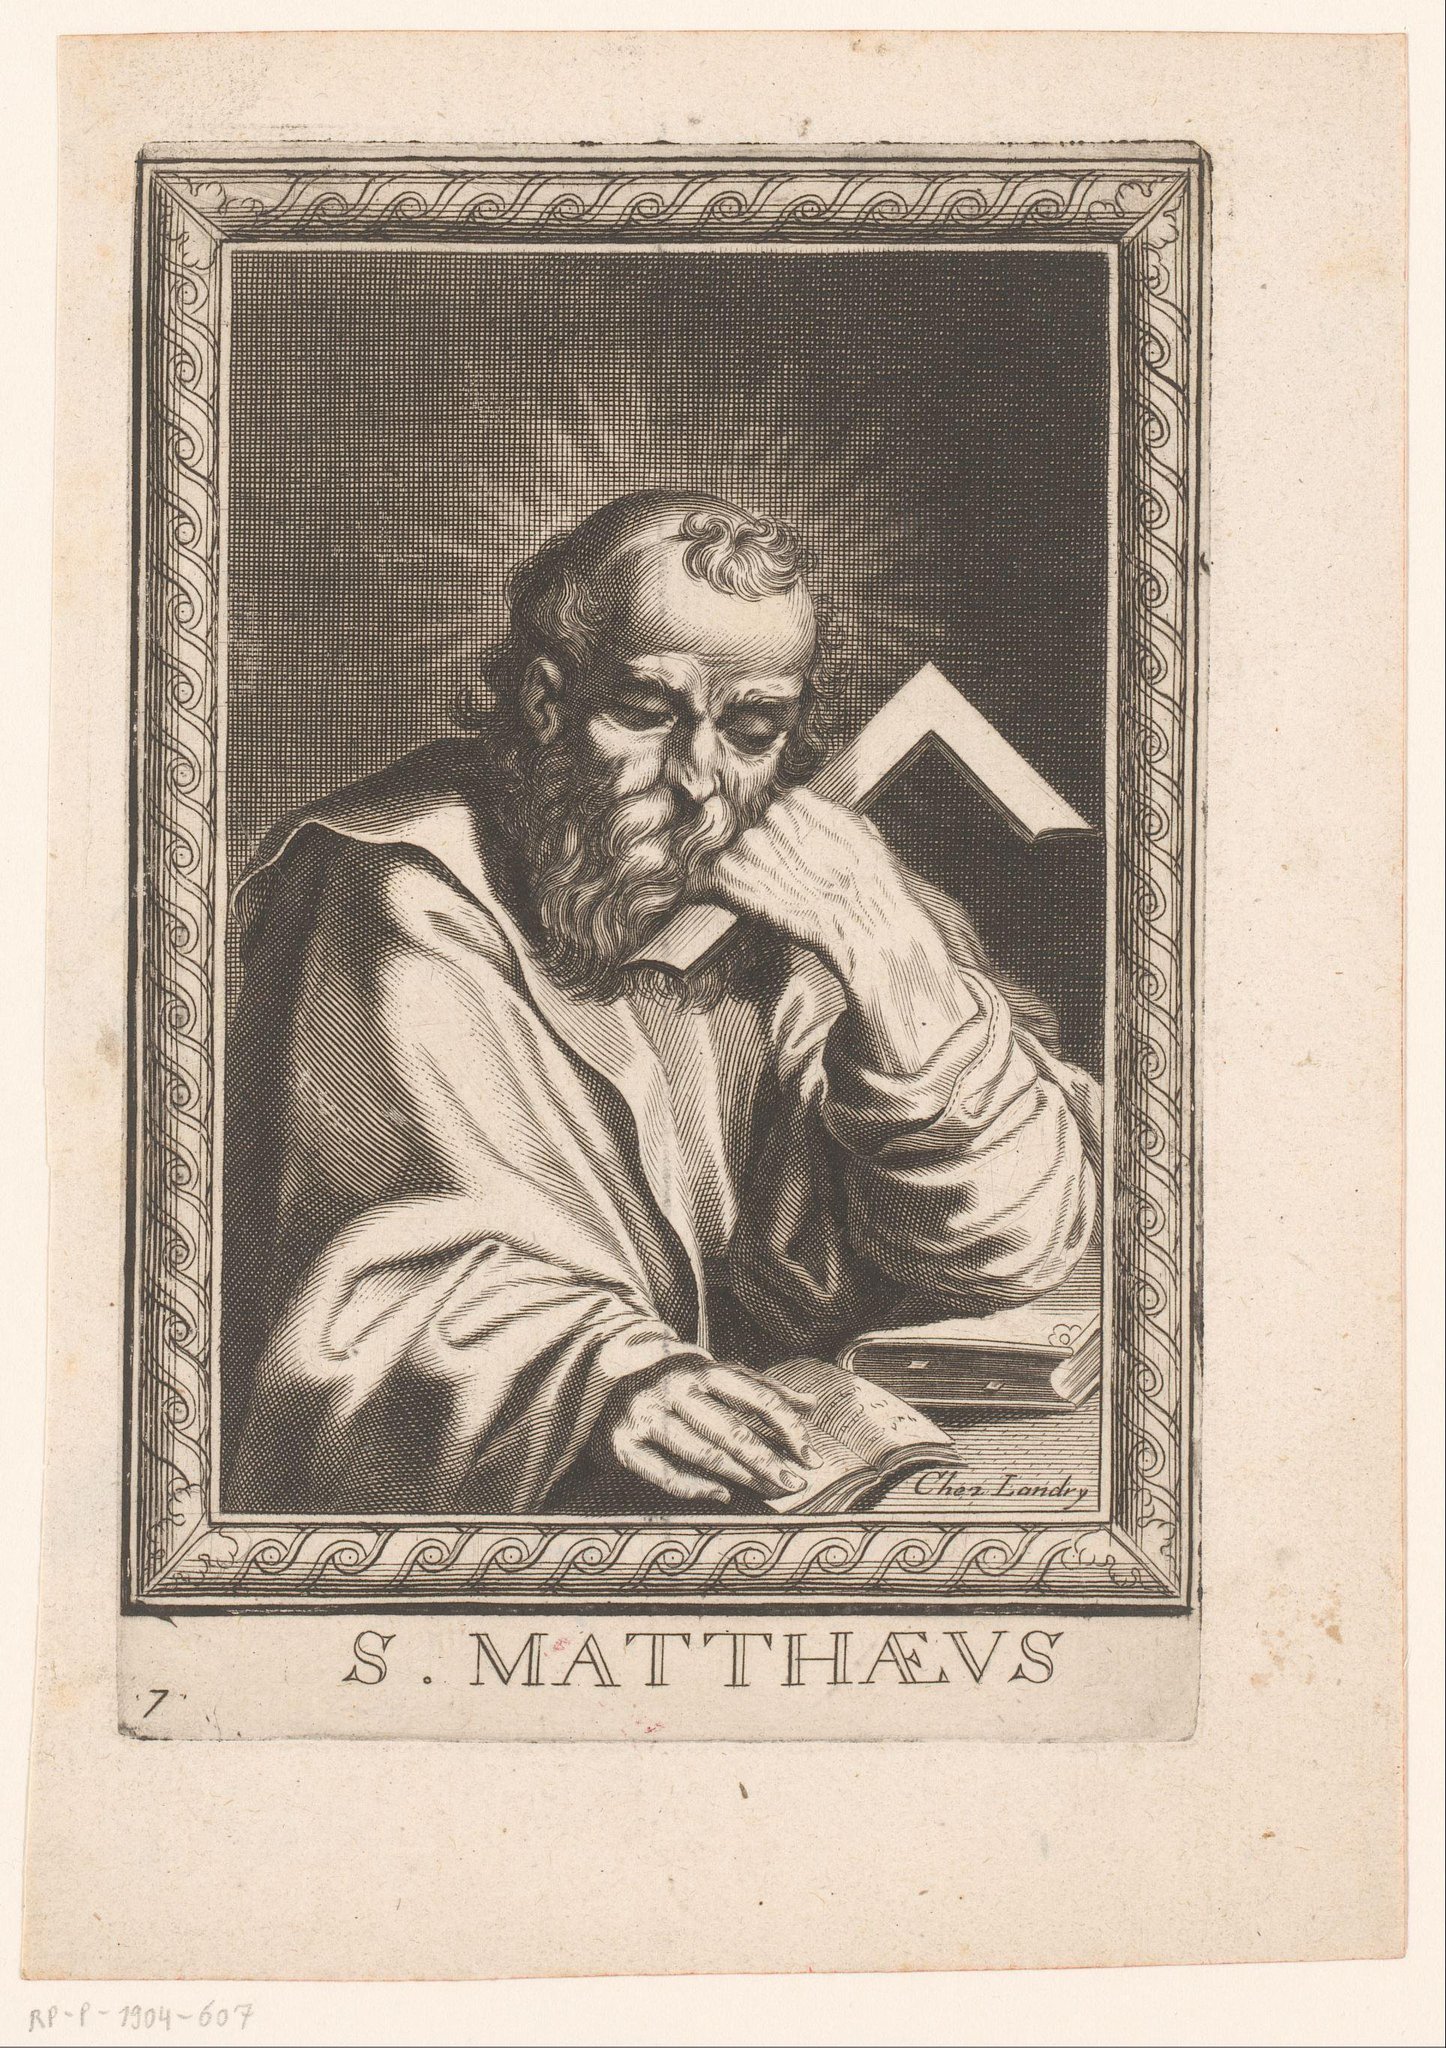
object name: print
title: S. Matthaeus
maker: pierre landry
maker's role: print maker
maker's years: 1630-1701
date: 1640-1701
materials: paper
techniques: engraving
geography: paris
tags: the apostle and evangelist matthew (mattheus); possible attributes: angel, axe, book, halberd, pen and inkhorn, purse, scroll, square, sword - portrait of male saint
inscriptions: collector's mark: Lugt 2228